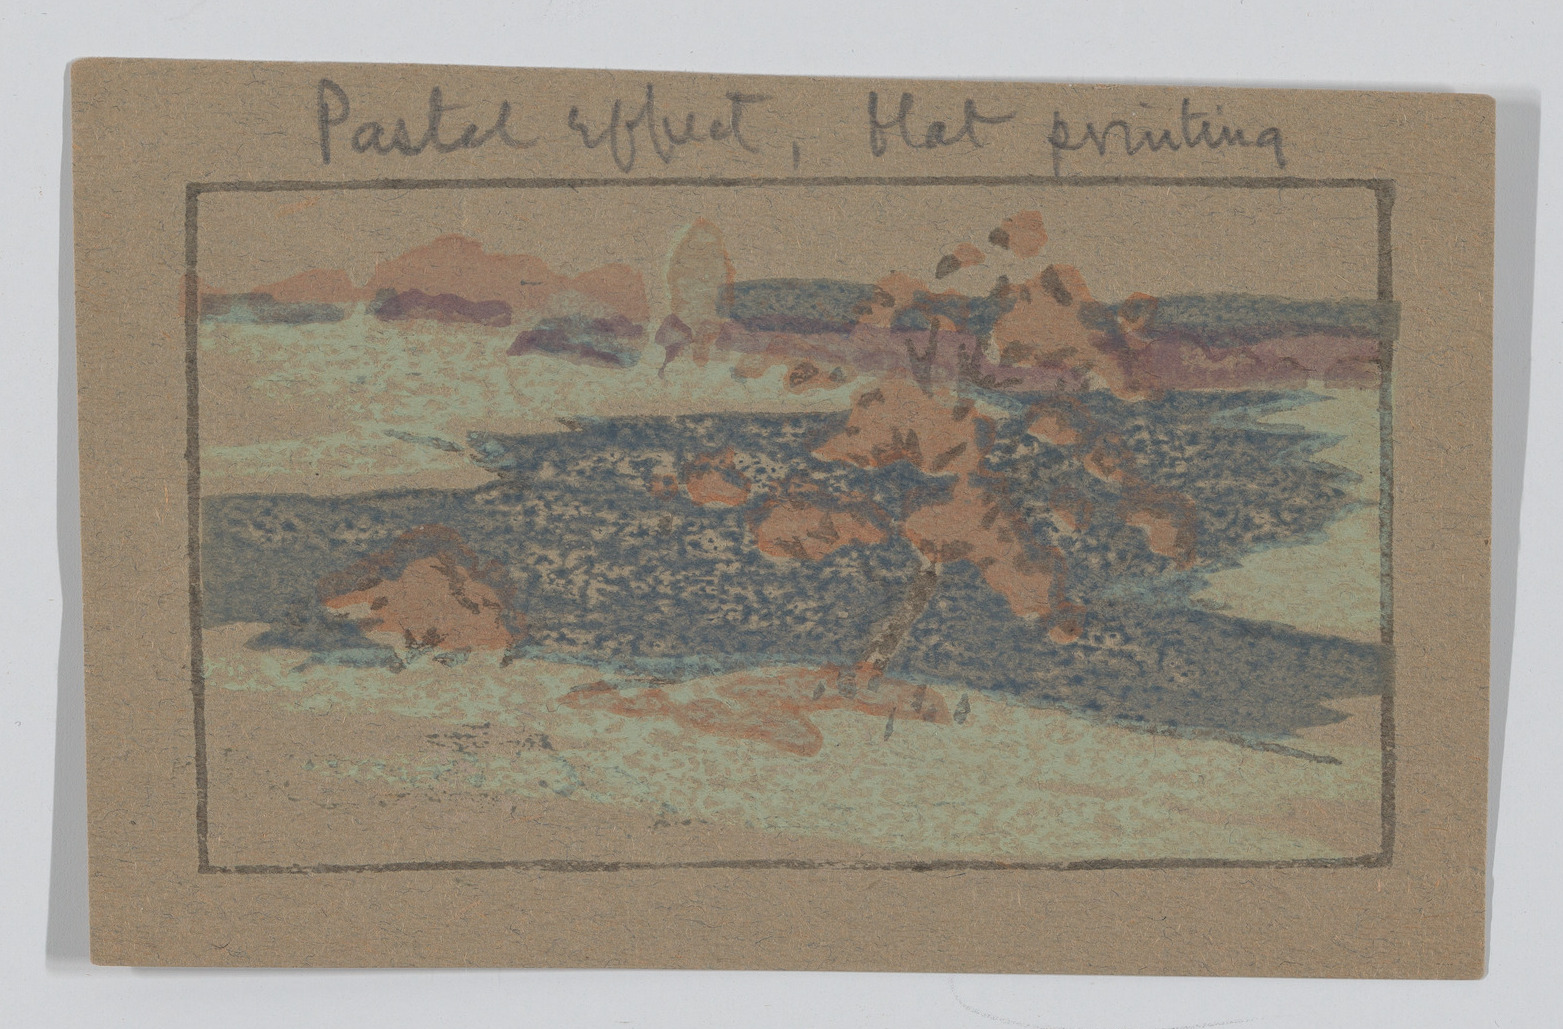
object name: woodcut, print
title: Nabby's Point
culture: american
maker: arthur wesley dow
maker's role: artist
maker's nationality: american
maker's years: 1857-1922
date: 1913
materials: paper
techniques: woodcut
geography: united states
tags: abstraction